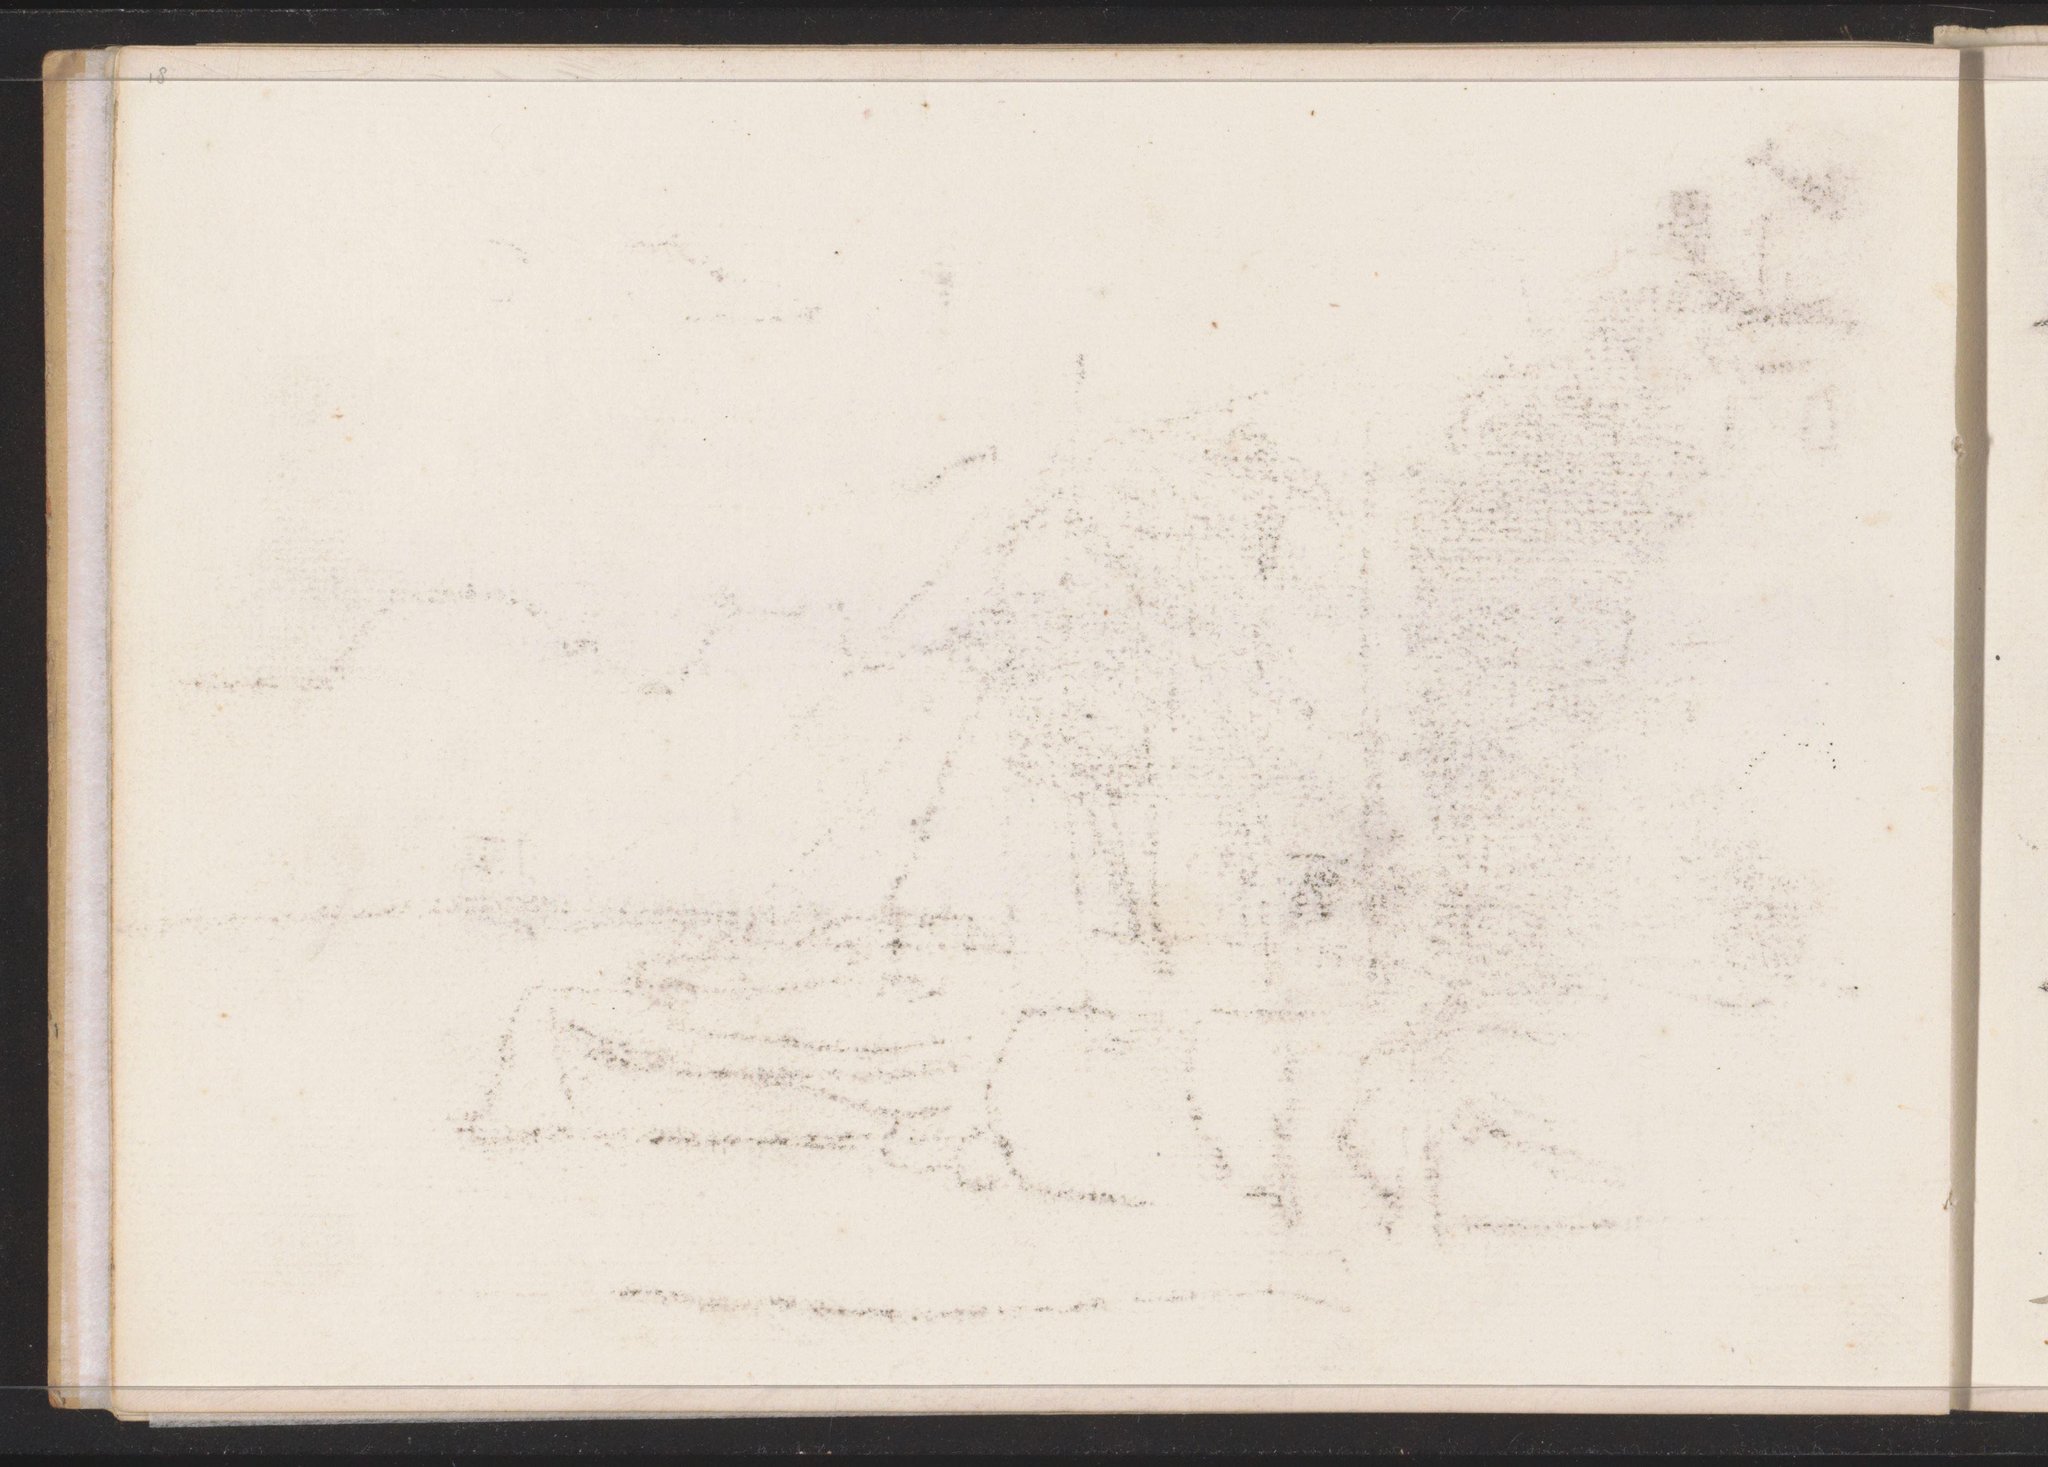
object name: sketchbook leaf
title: Abklatsch van de krijttekening op pagina 19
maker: willem witsen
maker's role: draughtsman, painter, print maker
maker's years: 1860-1923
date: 1897-1899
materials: paper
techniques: printmaking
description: Pagina 18 uit een schetsboek met 17 bladen.